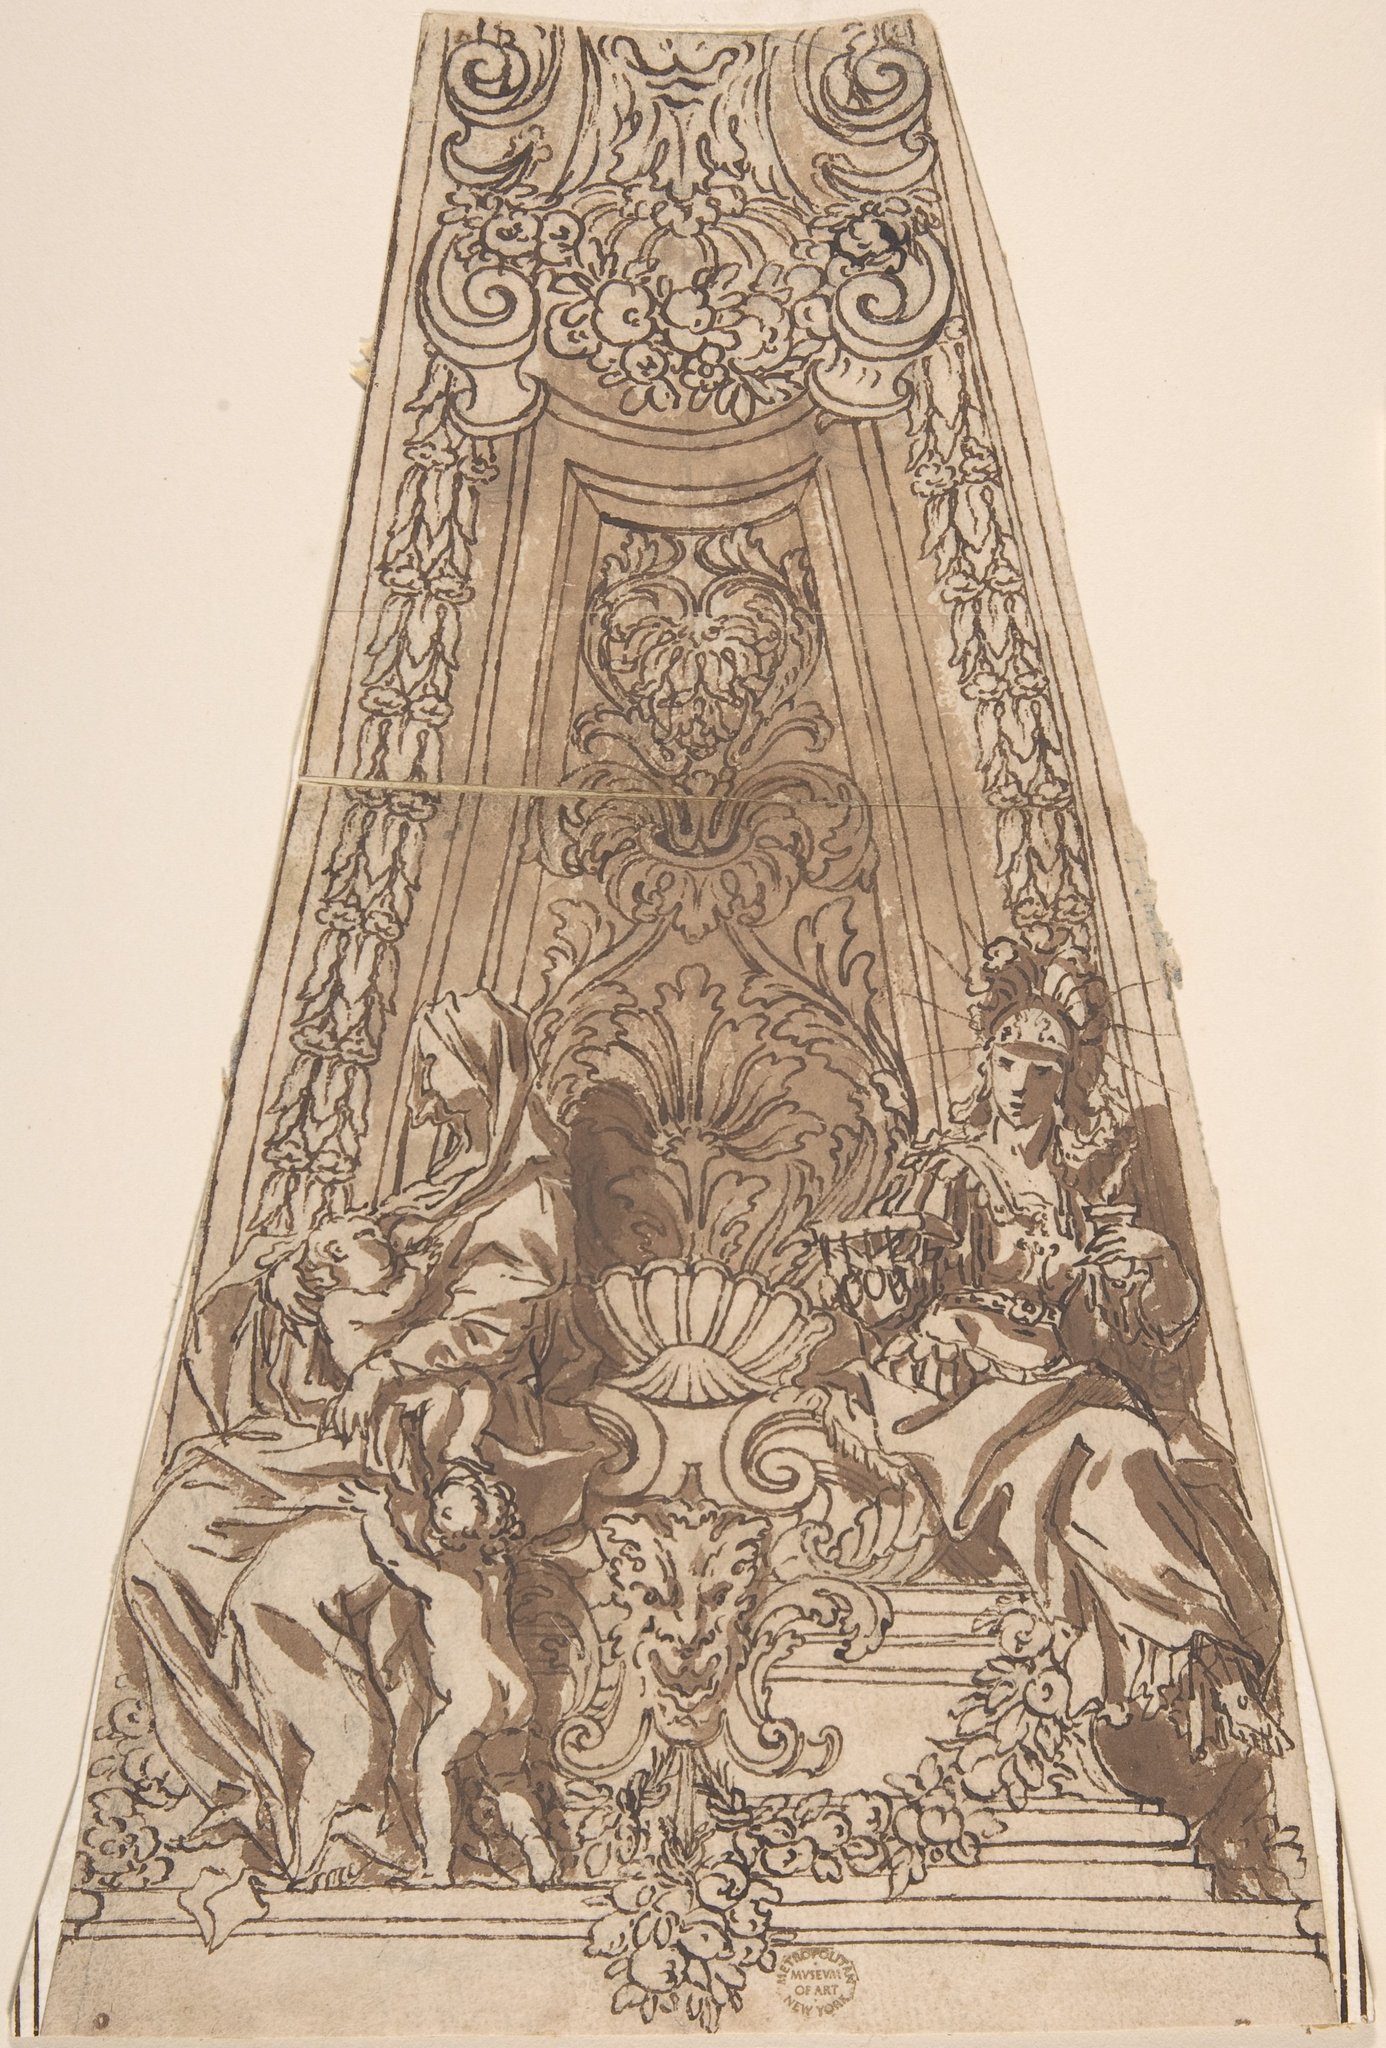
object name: drawing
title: Design for a Dome Compartment with Figures of Charity and Fortitude?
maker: anonymous, italian, roman-bolognese, 17th century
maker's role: artist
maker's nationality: italian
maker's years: 1600-1700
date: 1601-1700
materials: chalk, ink, paper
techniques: brush, pen, wash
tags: ornament,infants,women